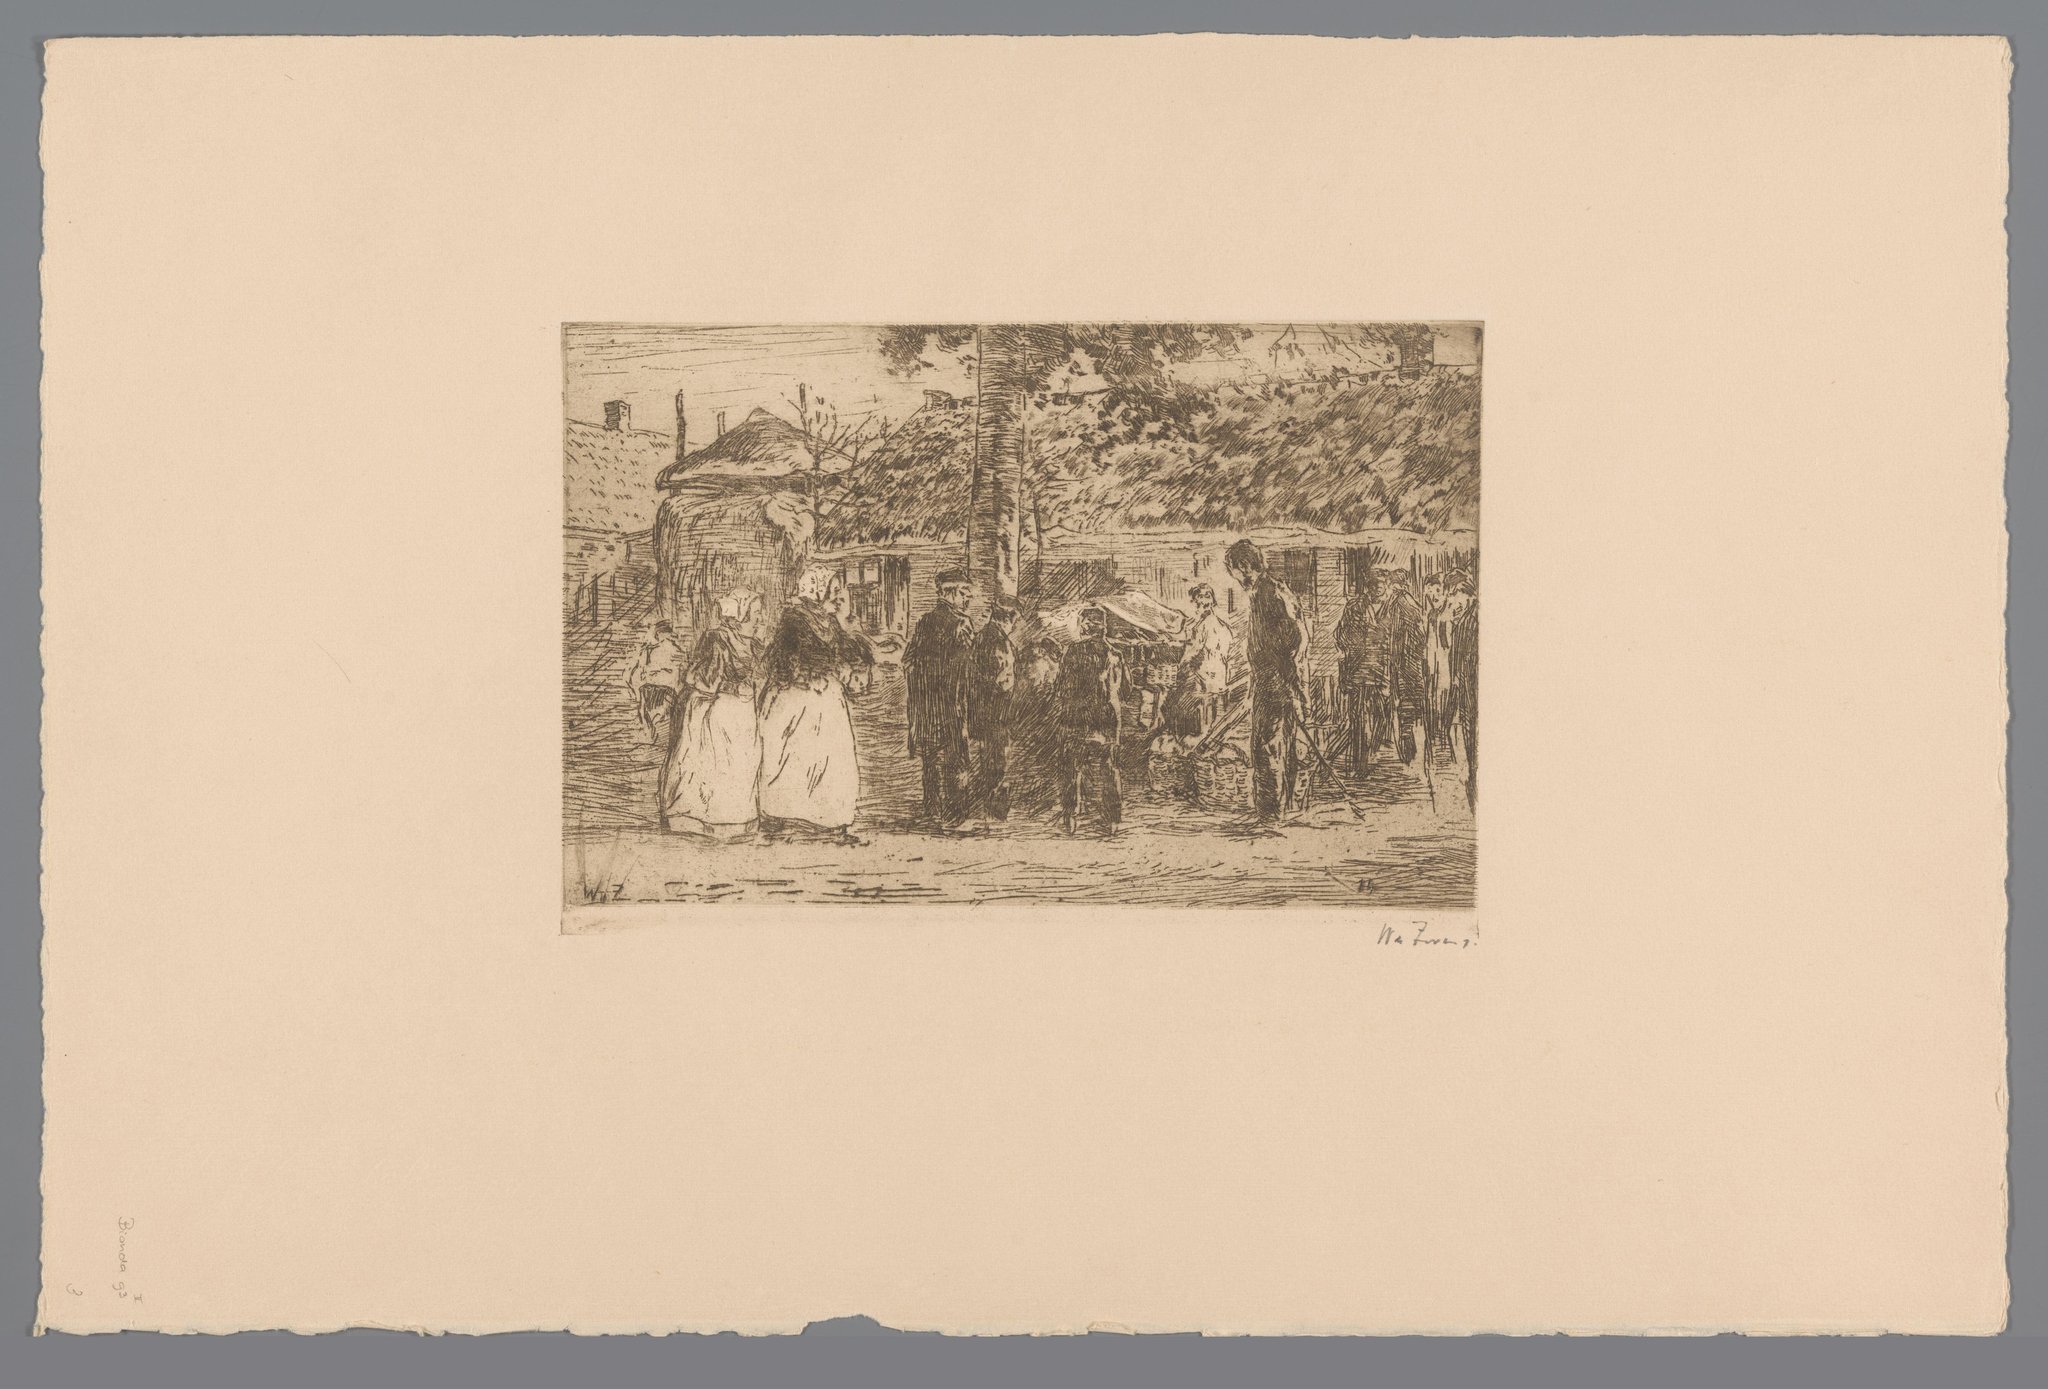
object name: print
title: Boeren op een dorpsmarkt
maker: willem de zwart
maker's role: draughtsman, painter, print maker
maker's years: 1862-1931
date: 1924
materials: paper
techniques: drypoint, etching, intaglio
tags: village, market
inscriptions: collector's mark: Lugt 2228, collector's mark: Lugt 2760